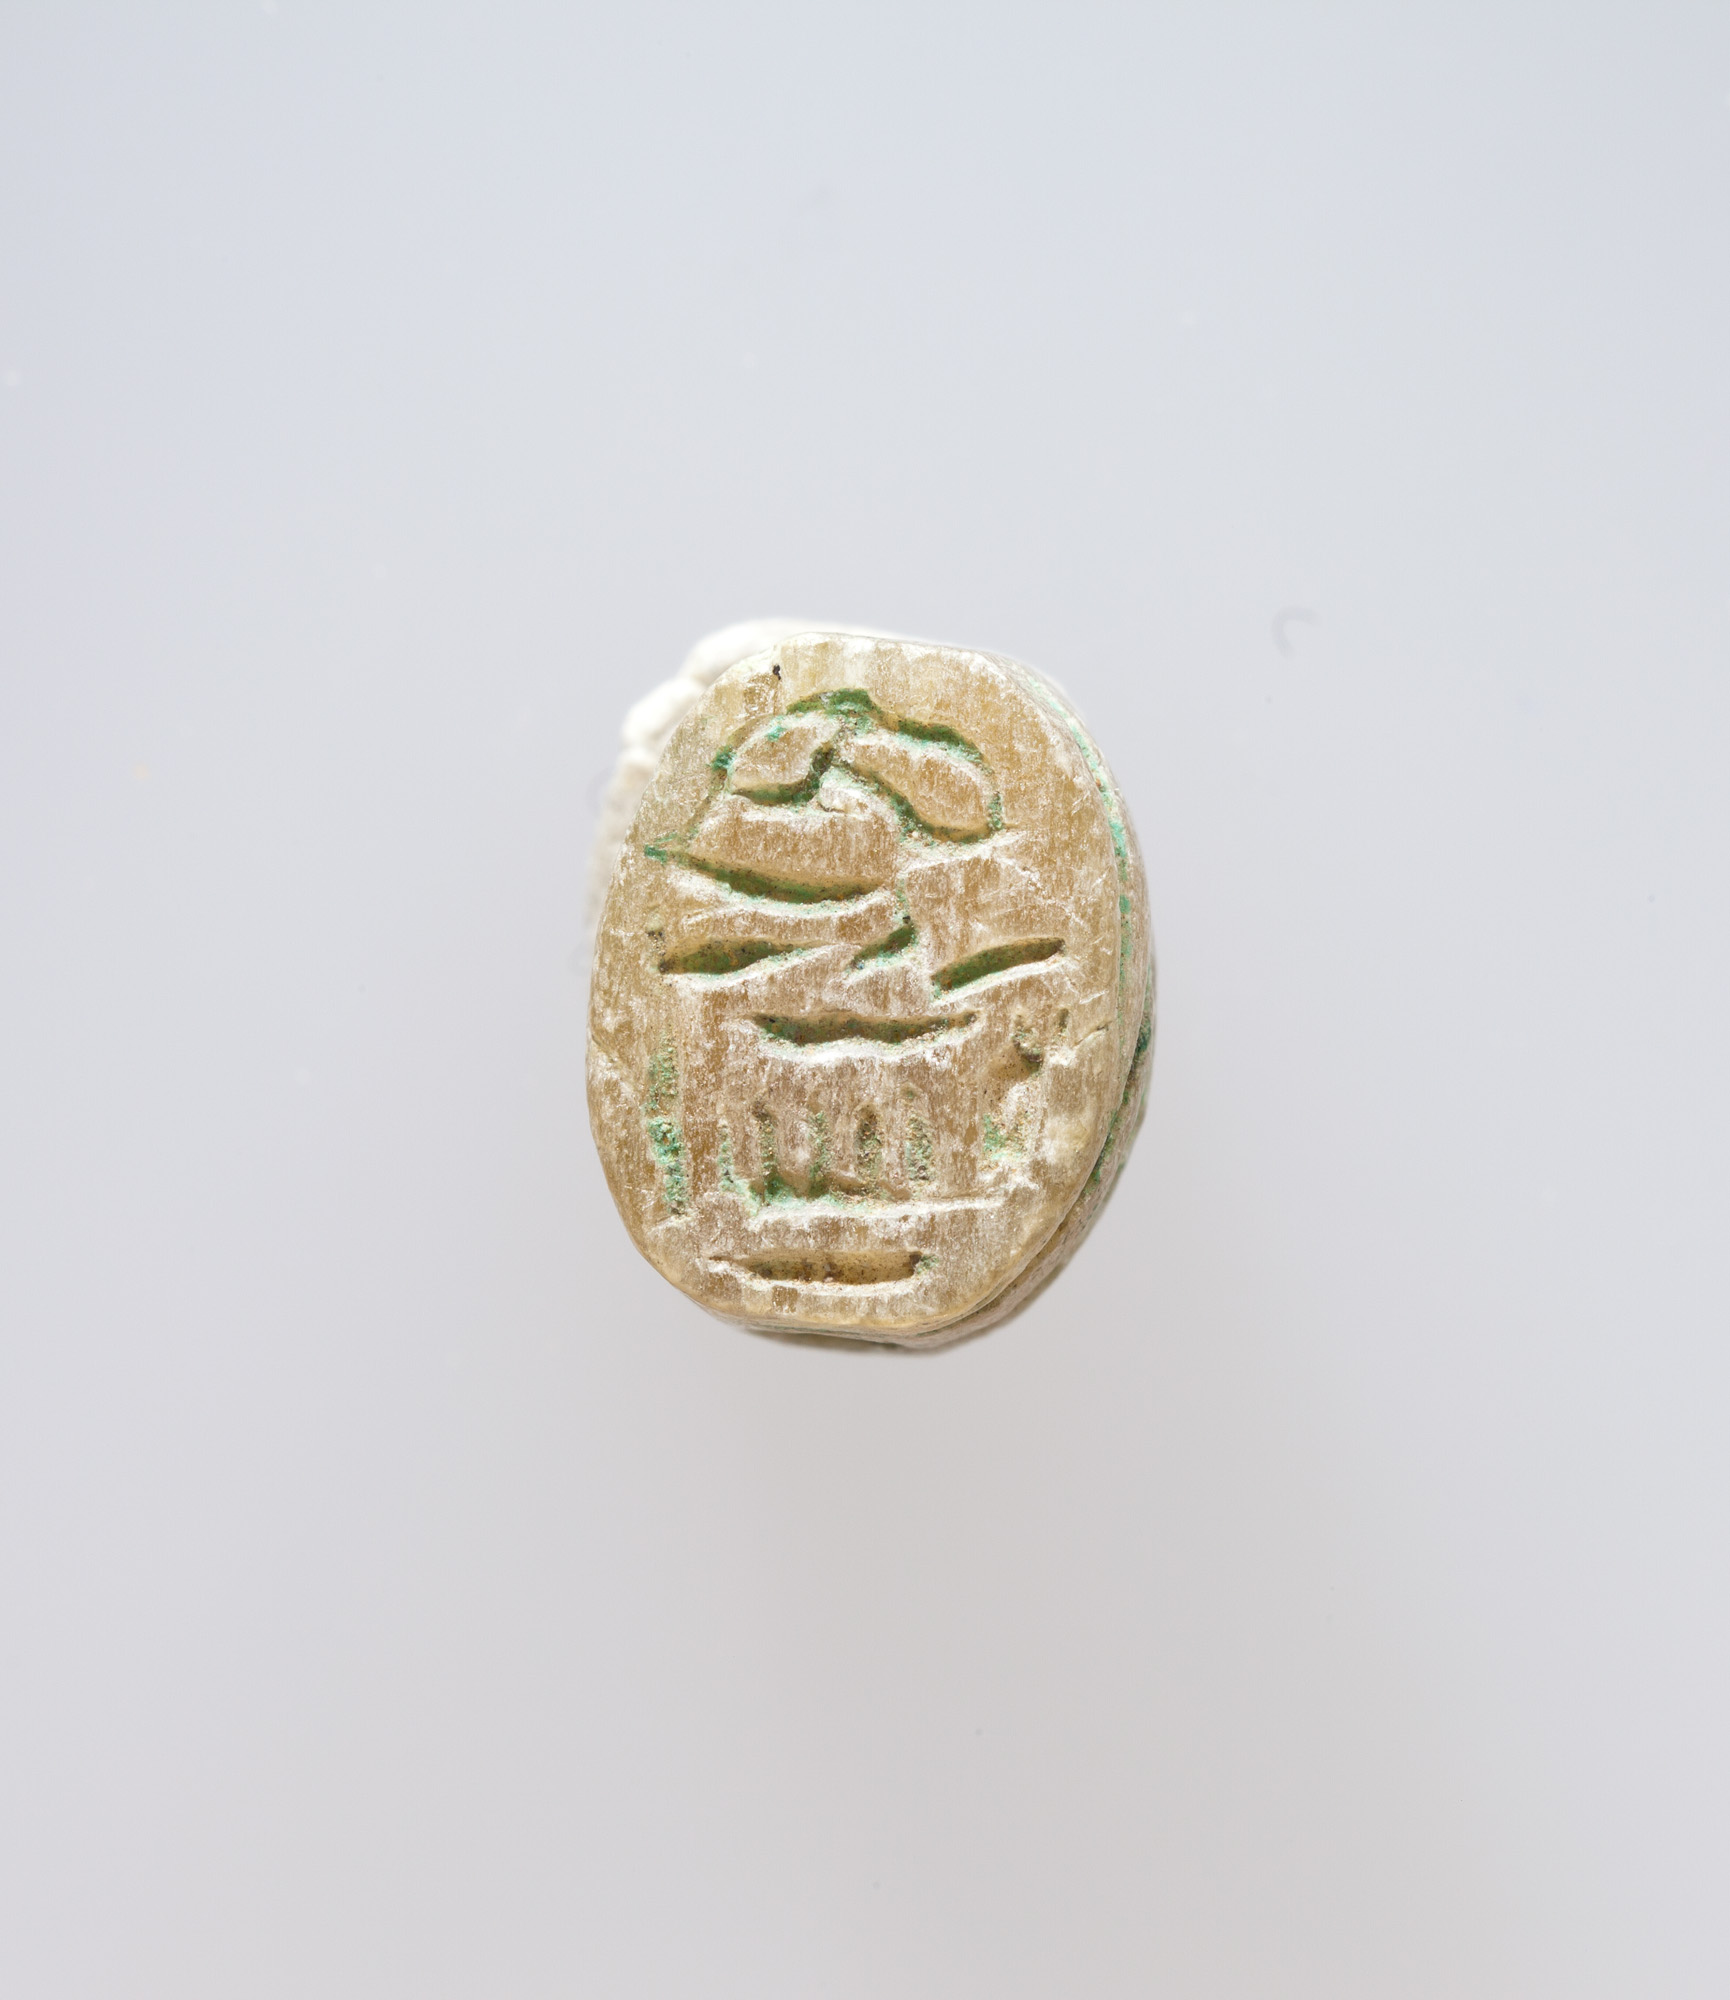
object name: scarab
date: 1479-1458 BCE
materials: faience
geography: egypt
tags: scarabs